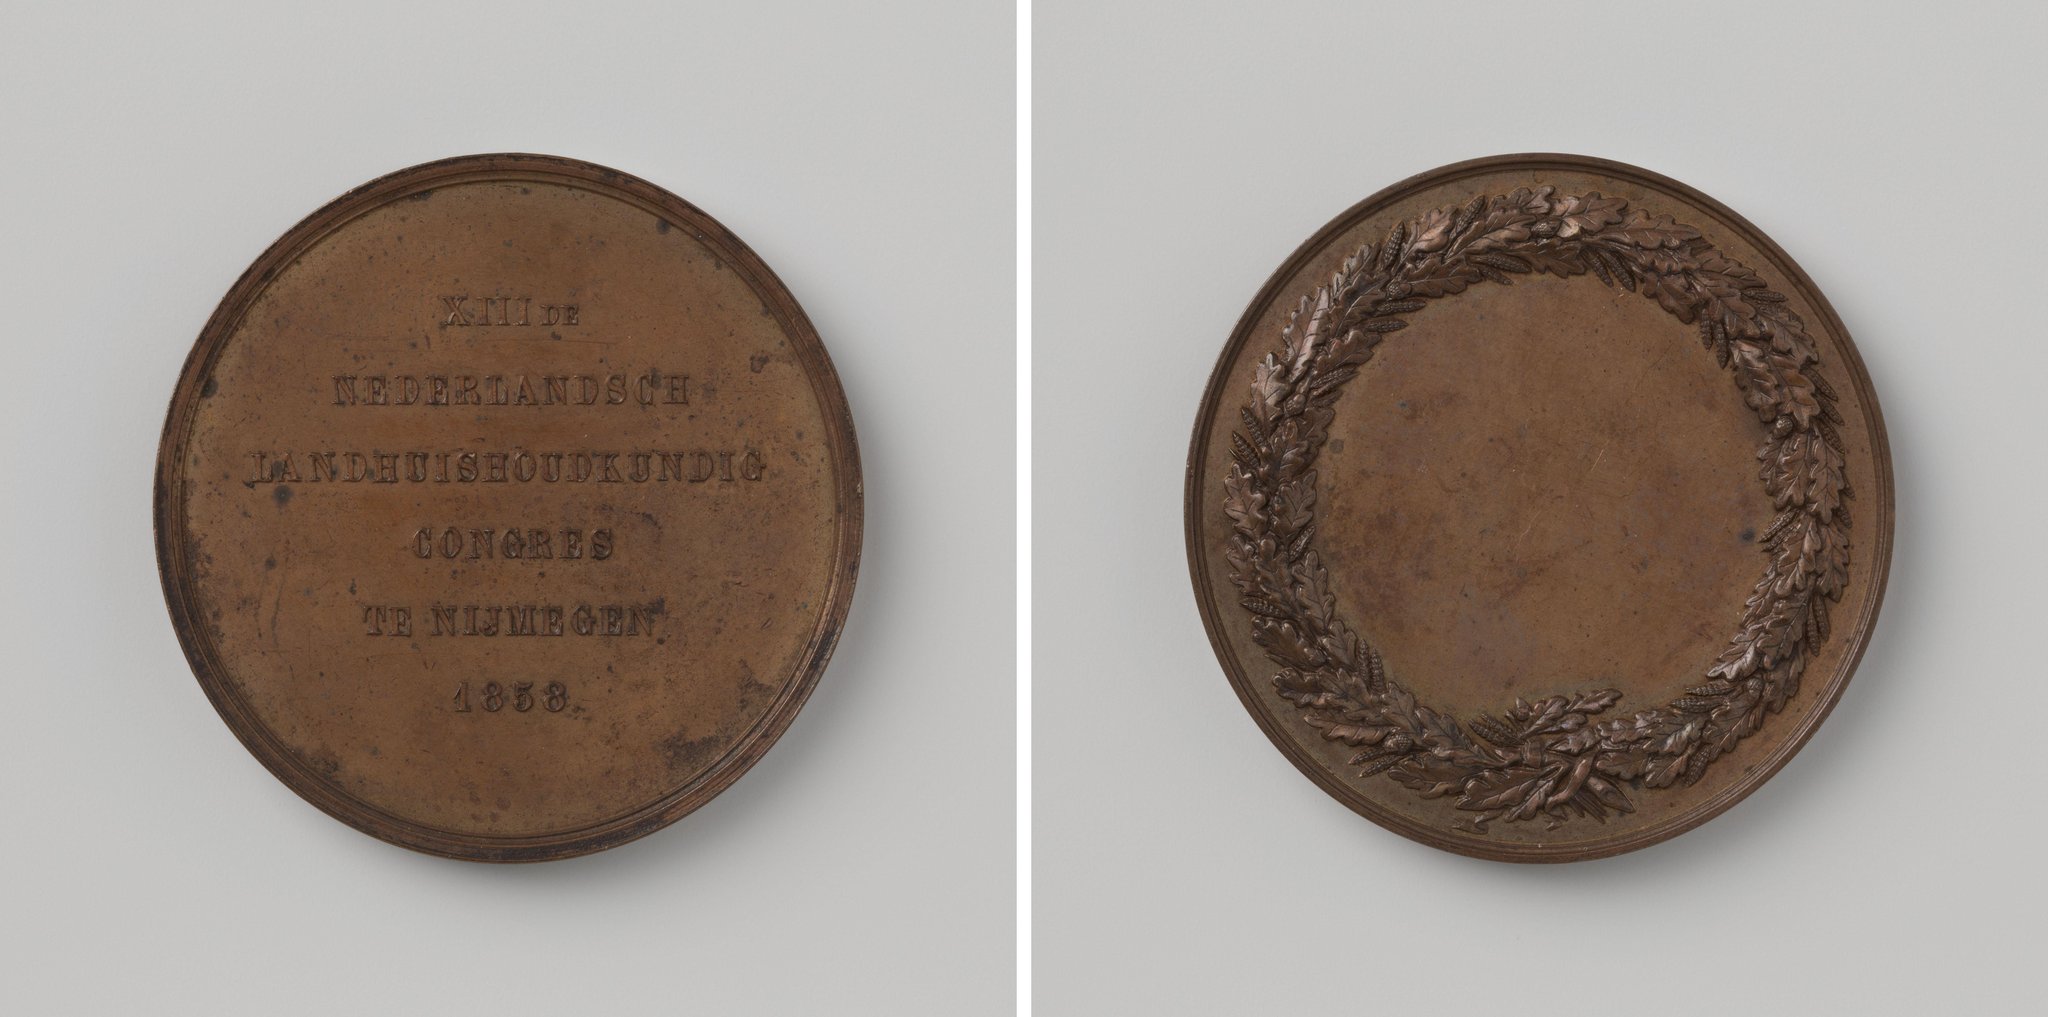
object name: medal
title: Twaalfde landhuiskundig congres te Nijmegen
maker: Anonymous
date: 1858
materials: bronze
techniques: striking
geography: netherlands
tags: nijmegen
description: Bronzen penning. Voorzijde: opschrift. Keerzijde: blanco veld binnen krans van eikeloof en korenaren